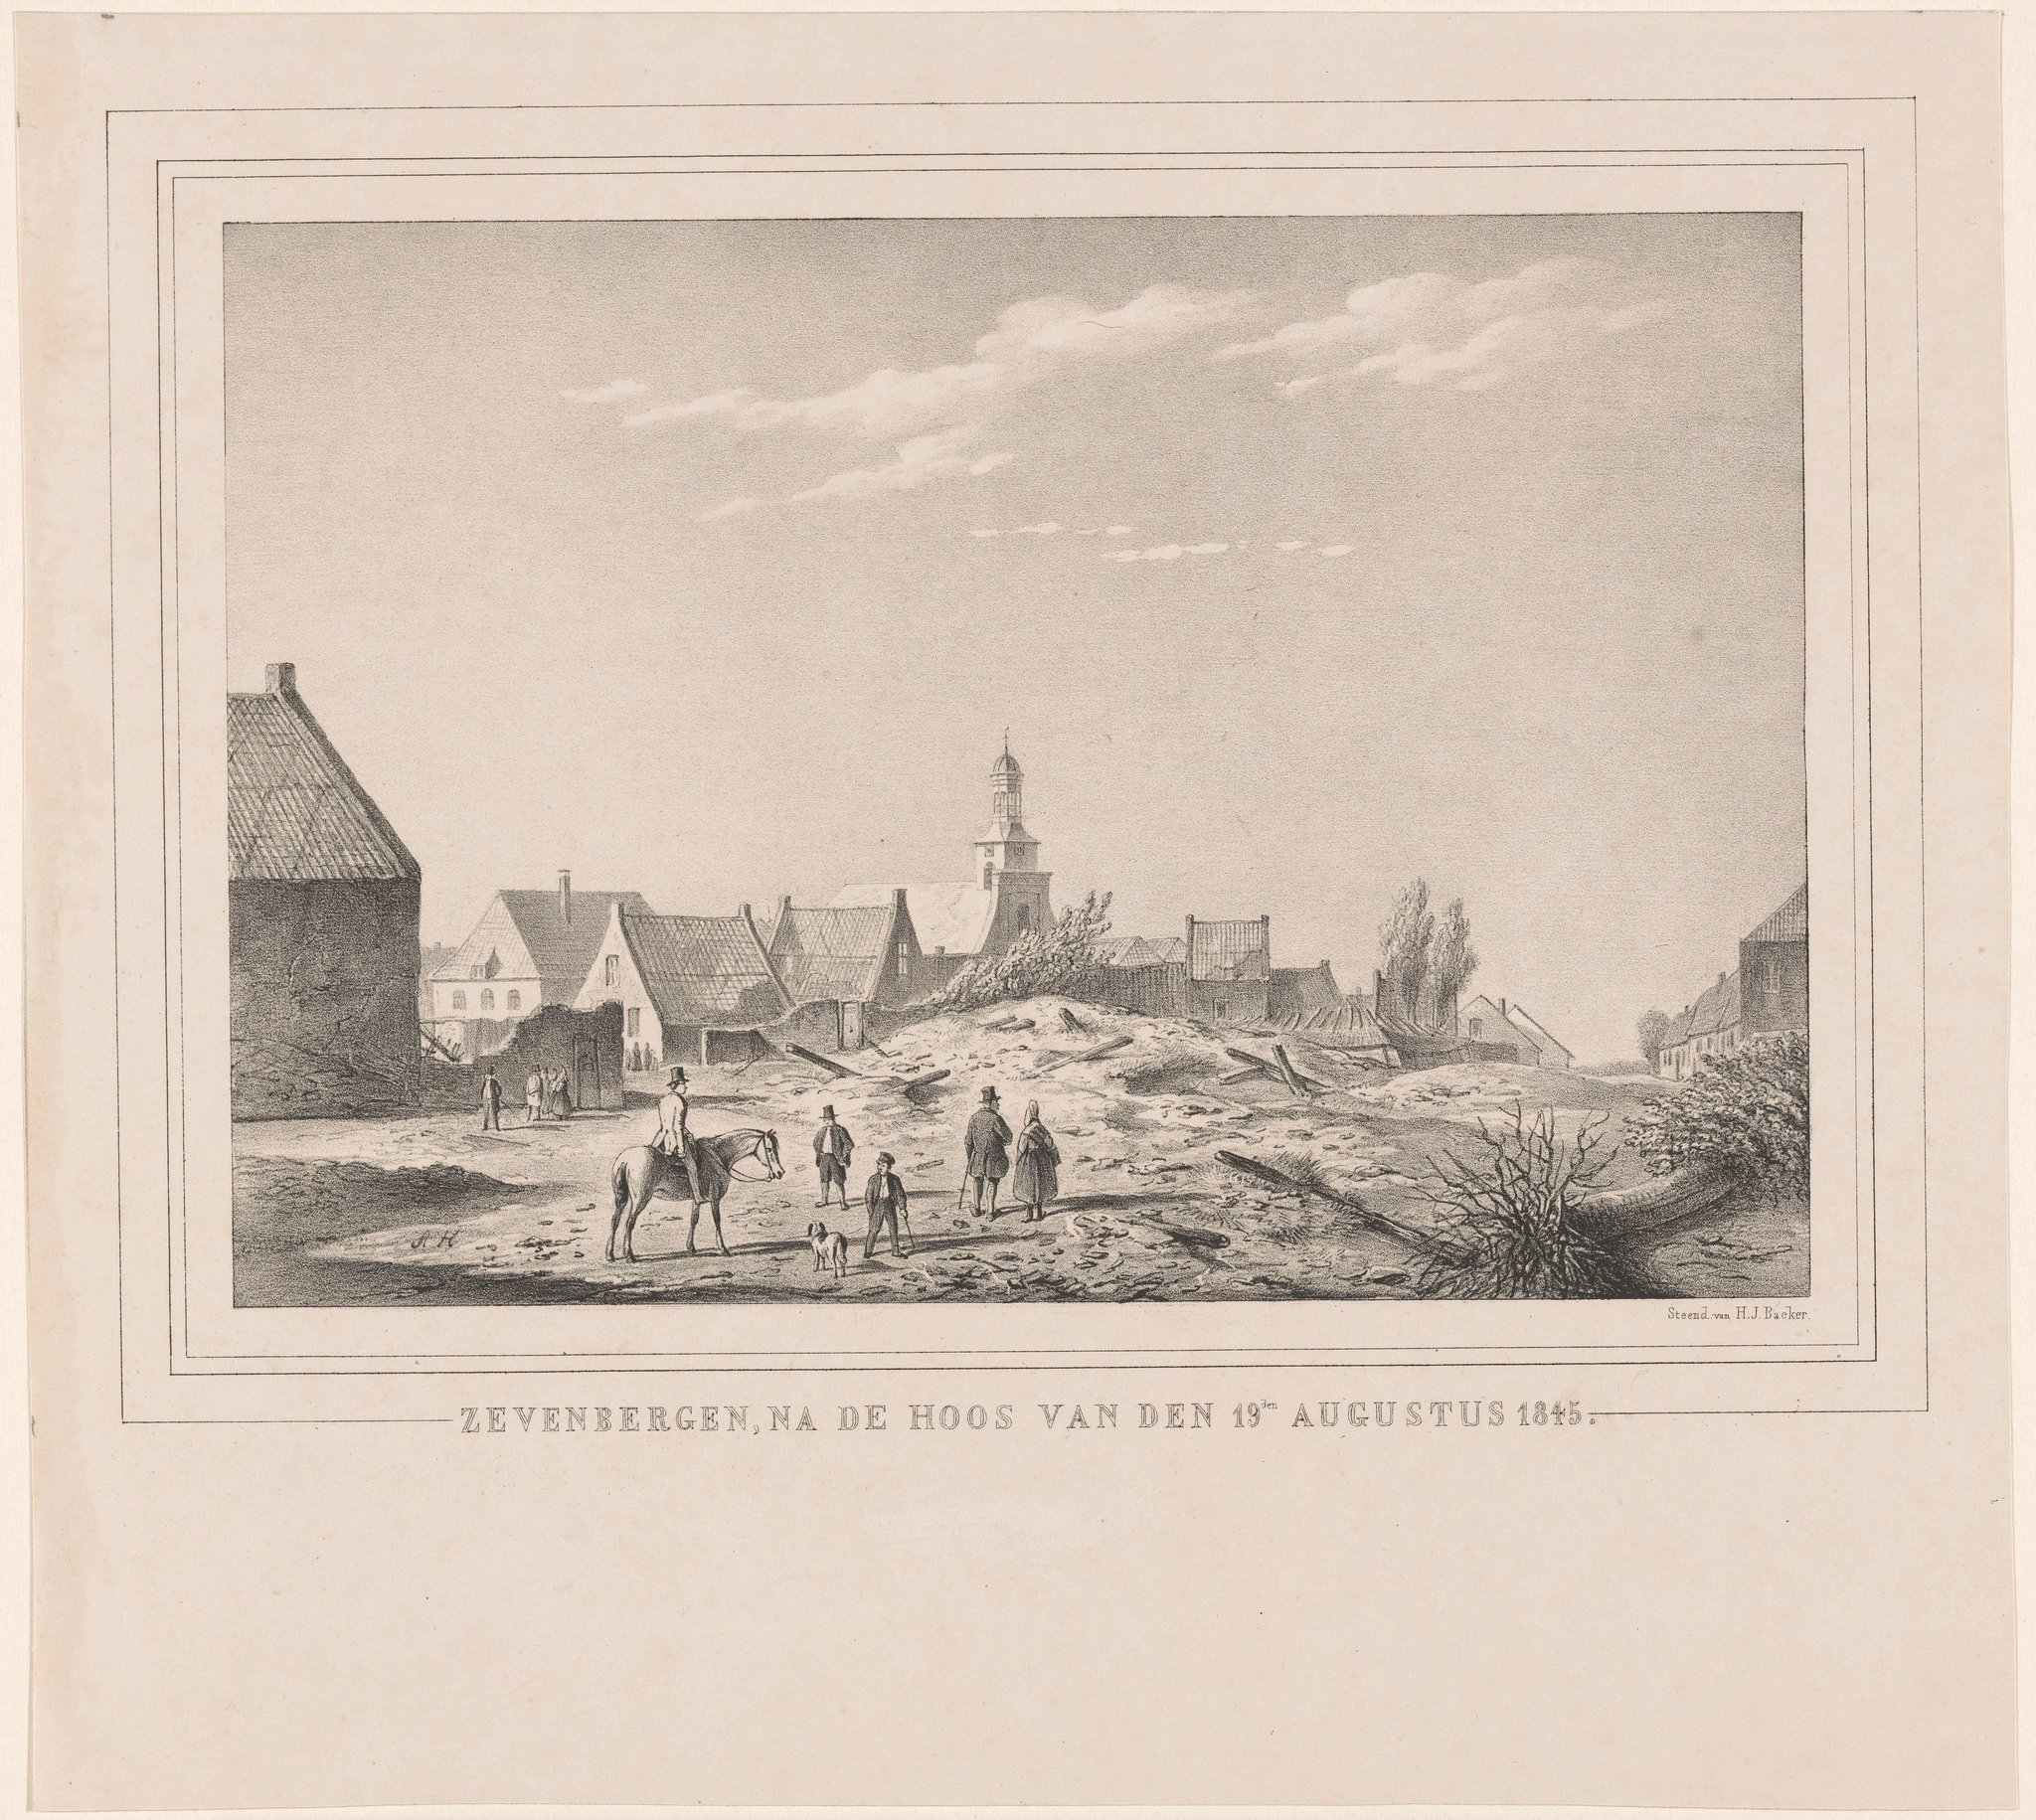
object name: print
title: Zevenbergen, na de hoos van den 19den augustus 1845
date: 1845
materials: paper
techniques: lithograph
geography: netherlands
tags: whirlwind, cyclone, hurricane, typhoon, tornado on land, village, ruin of a dwelling, house, castle, etc.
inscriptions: collector's mark: Lugt 2228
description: Gezicht van de ruïnes in het dorp Zevenbergen, na de windhoos van 19 augustus 1845. Zie ook de pendant